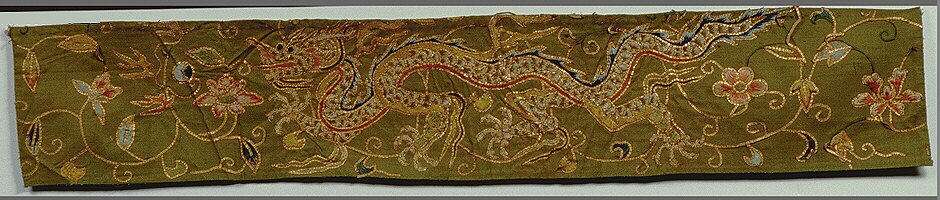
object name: panel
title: Horizontal Panel with Profile Dragon amid Flowers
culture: chinese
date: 1601-1800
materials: metal thread, silk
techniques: embroidery, weave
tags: dragons,flowers,leaves